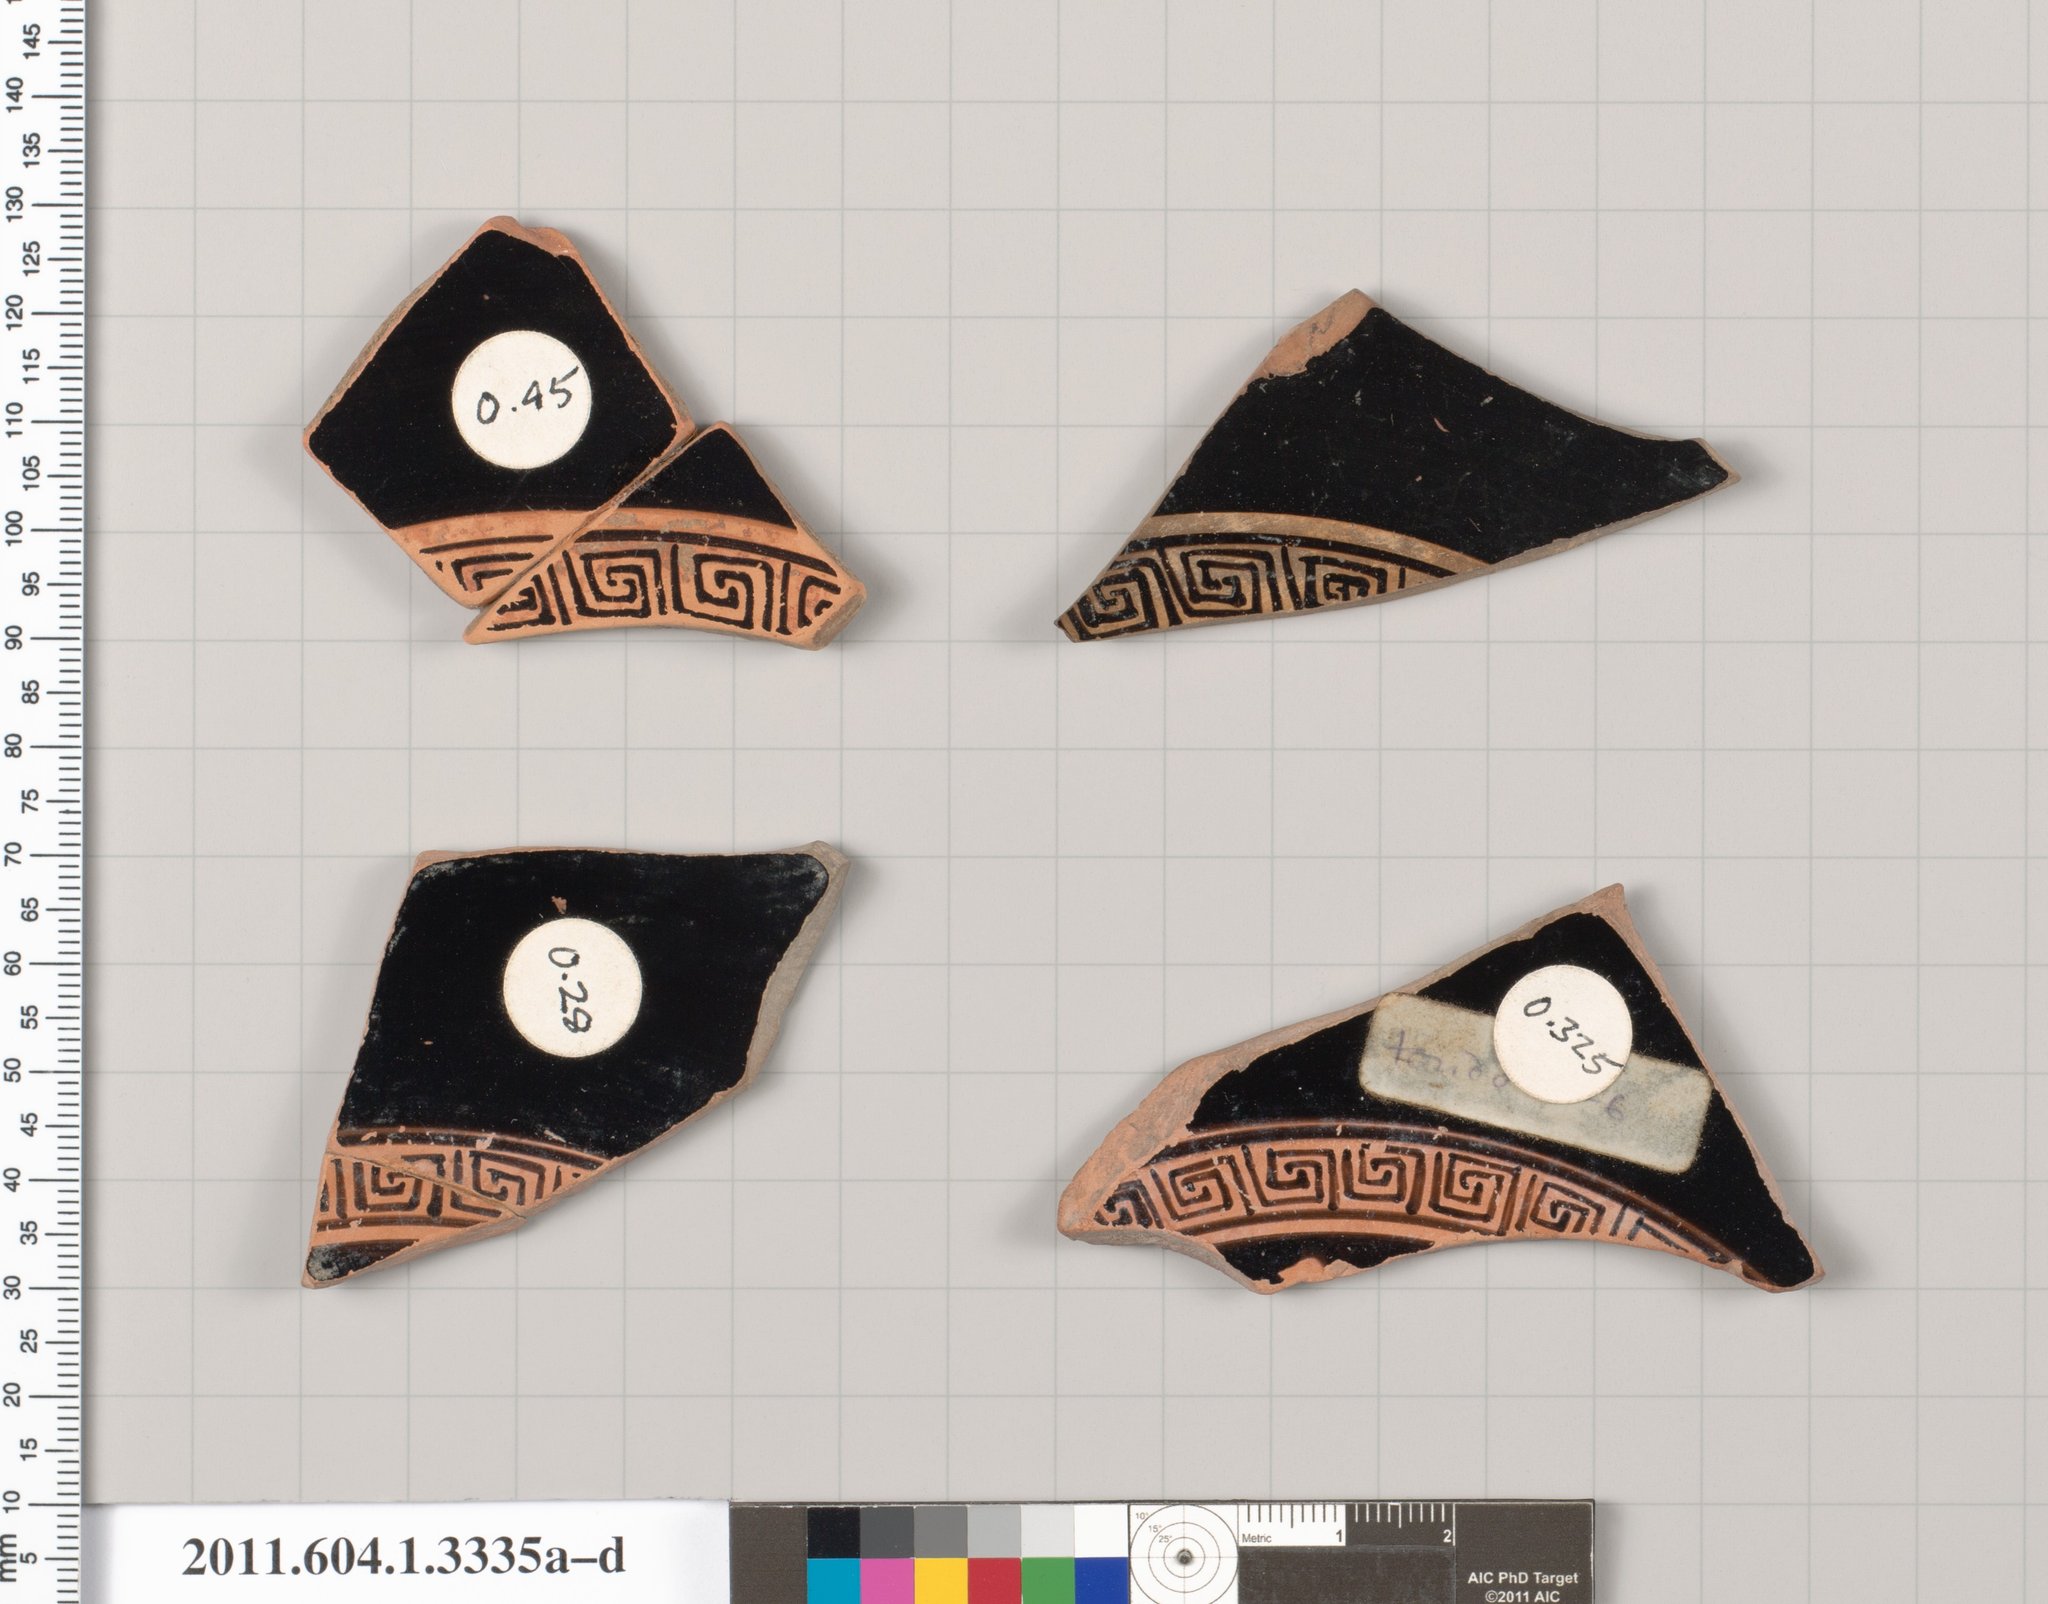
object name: kylix fragment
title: Terracotta fragments of kylikes (drinking cups)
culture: greek, attic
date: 500-470 BCE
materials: terracotta